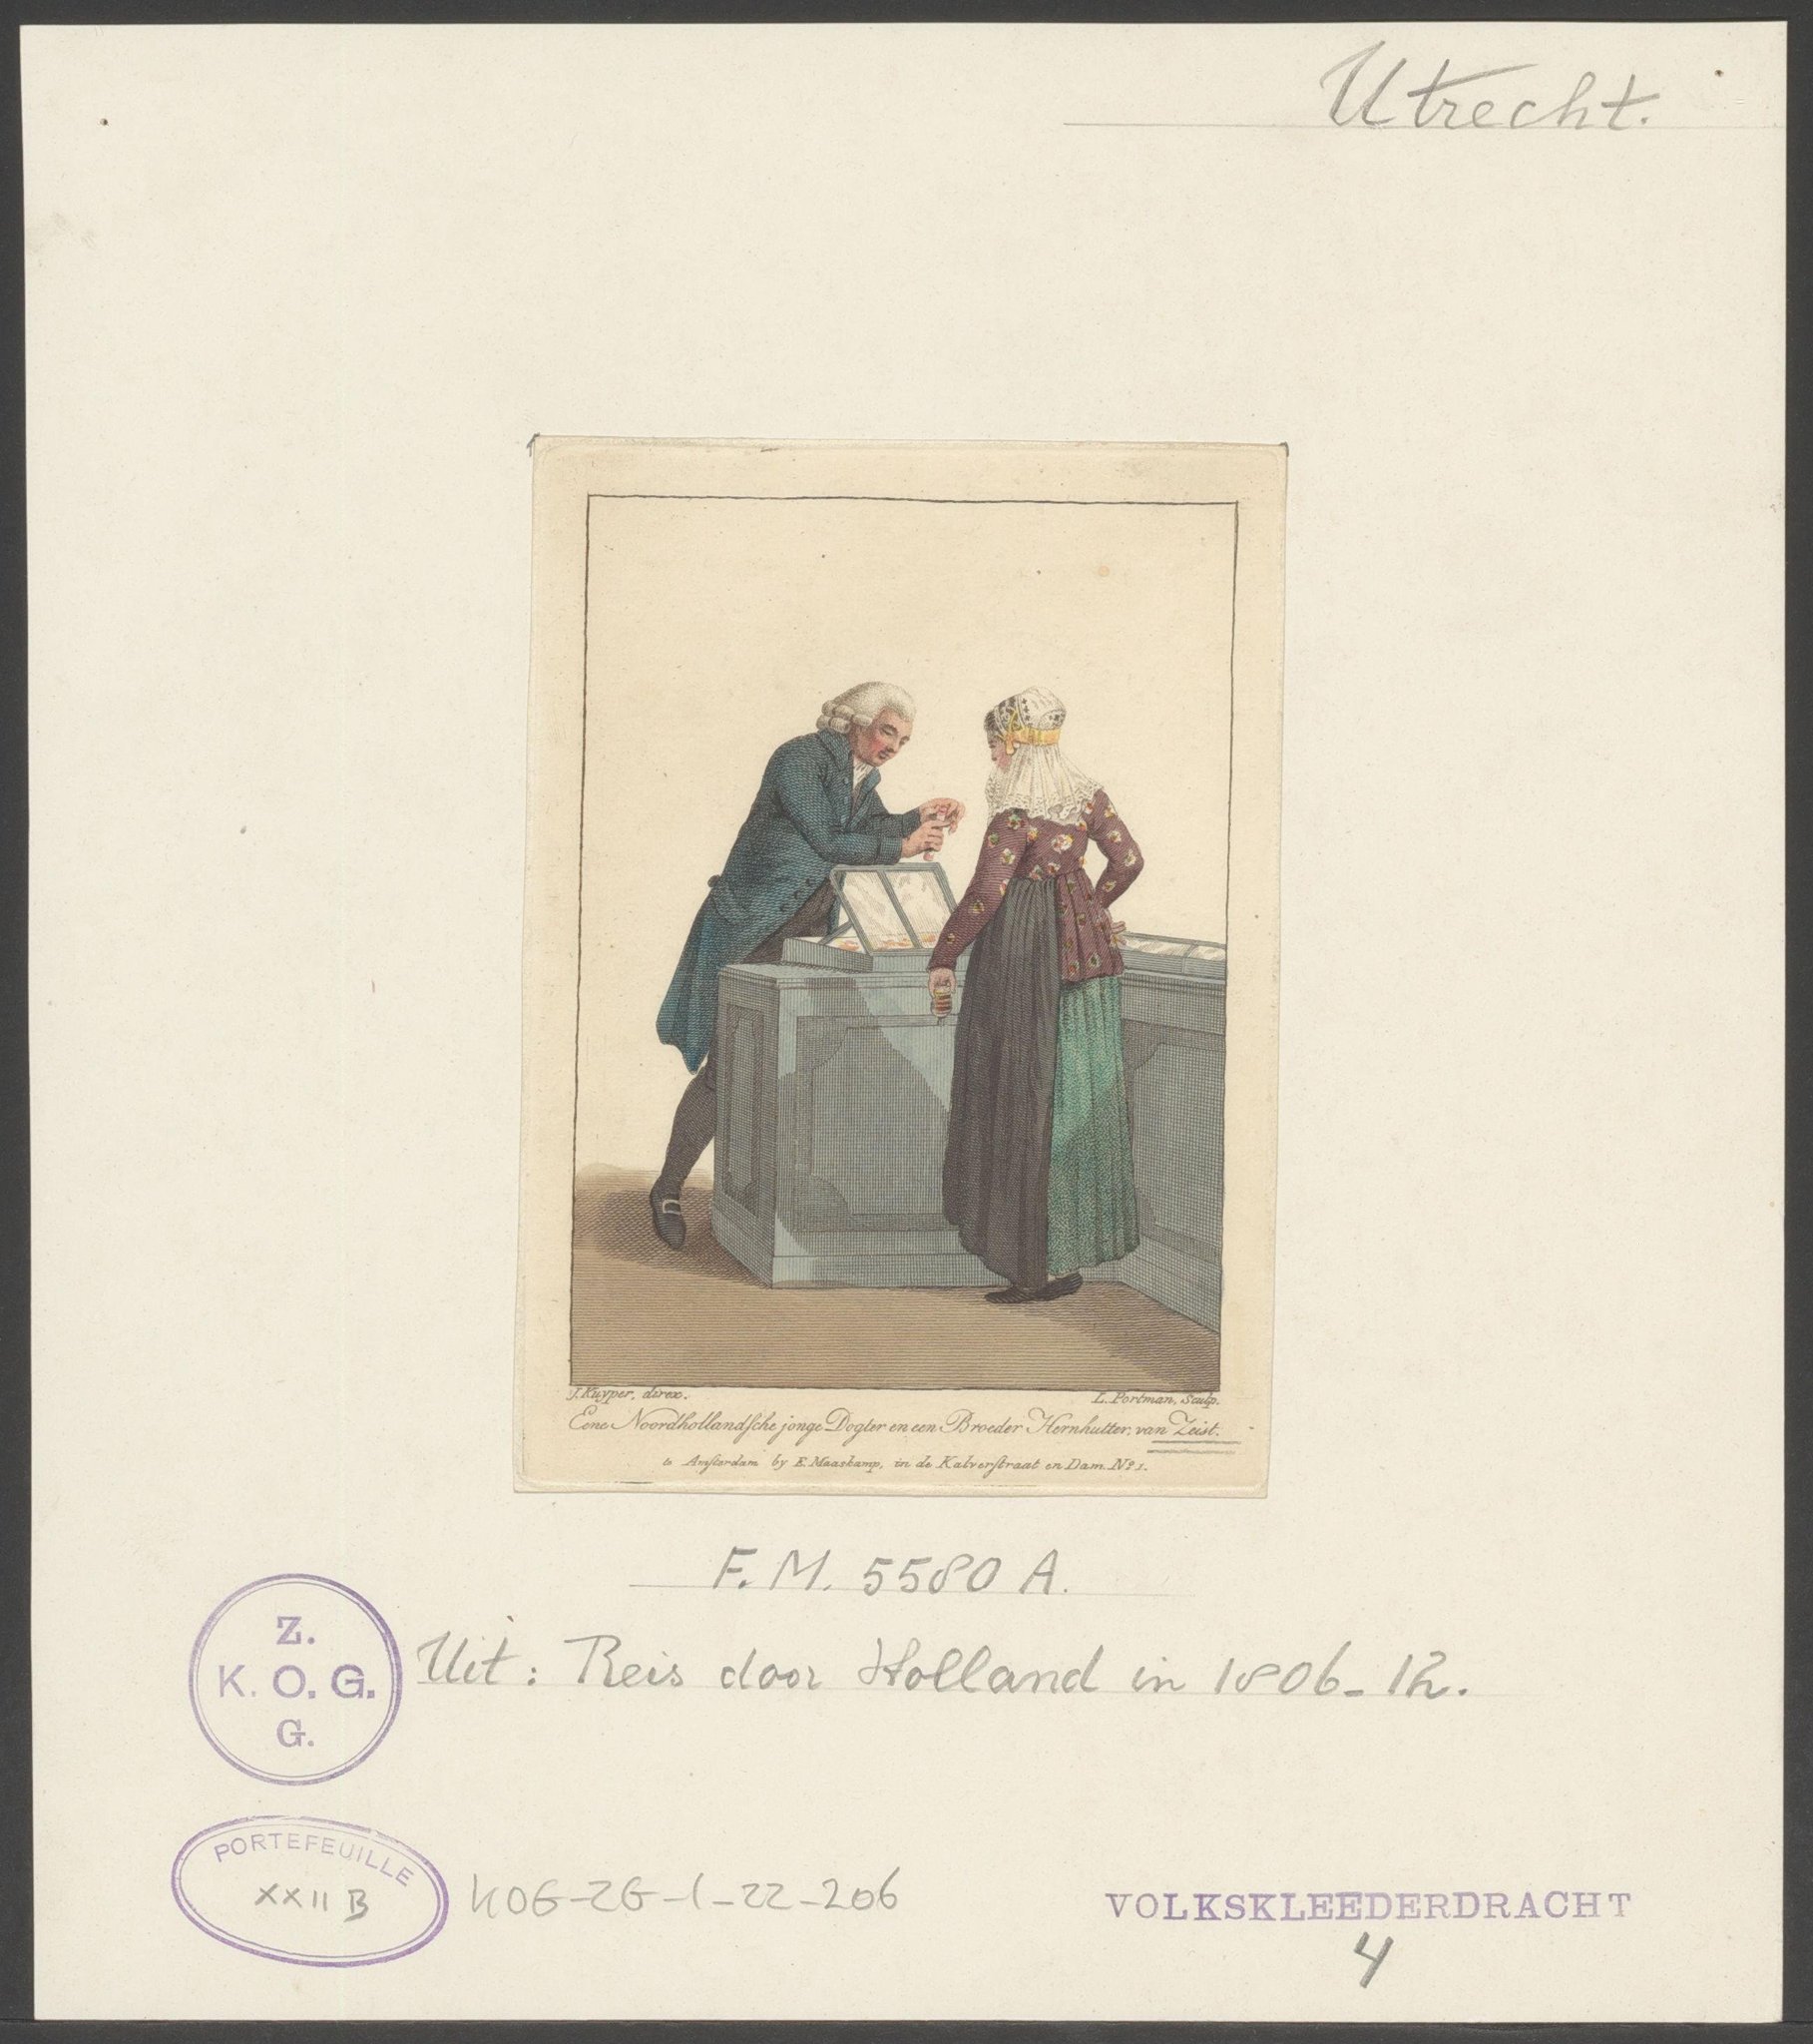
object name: print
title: Winkelier van de Evangelische Broedergemeente met een klant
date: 1813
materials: paper, watercolor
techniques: etching, hand coloring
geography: netherlands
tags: shop, store, clothes, costume (+ women's clothes), folk costume, regional costume, clothes, costume, zeist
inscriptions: collector's mark: Lugt 1641, collector's mark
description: Een winkelier (met pruik) van de Evangelische Broedergemeente toont een naaldenkoker aan een de klant, een jonge vrouw uit Alkmaar. De man behoort tot de Evangelische Broedergemeente (Hernhutters) te Zeist. Onderdeel van de verkleinde kopieën uit 1806 naar de platen van Nederlandse klederdrachten uit de jaren 1803-1807. Onderwerpsrubrieken binnen de Atlas Zeden en Gewoonten: De Kleeding, Volkskleederdracht, Utrecht.